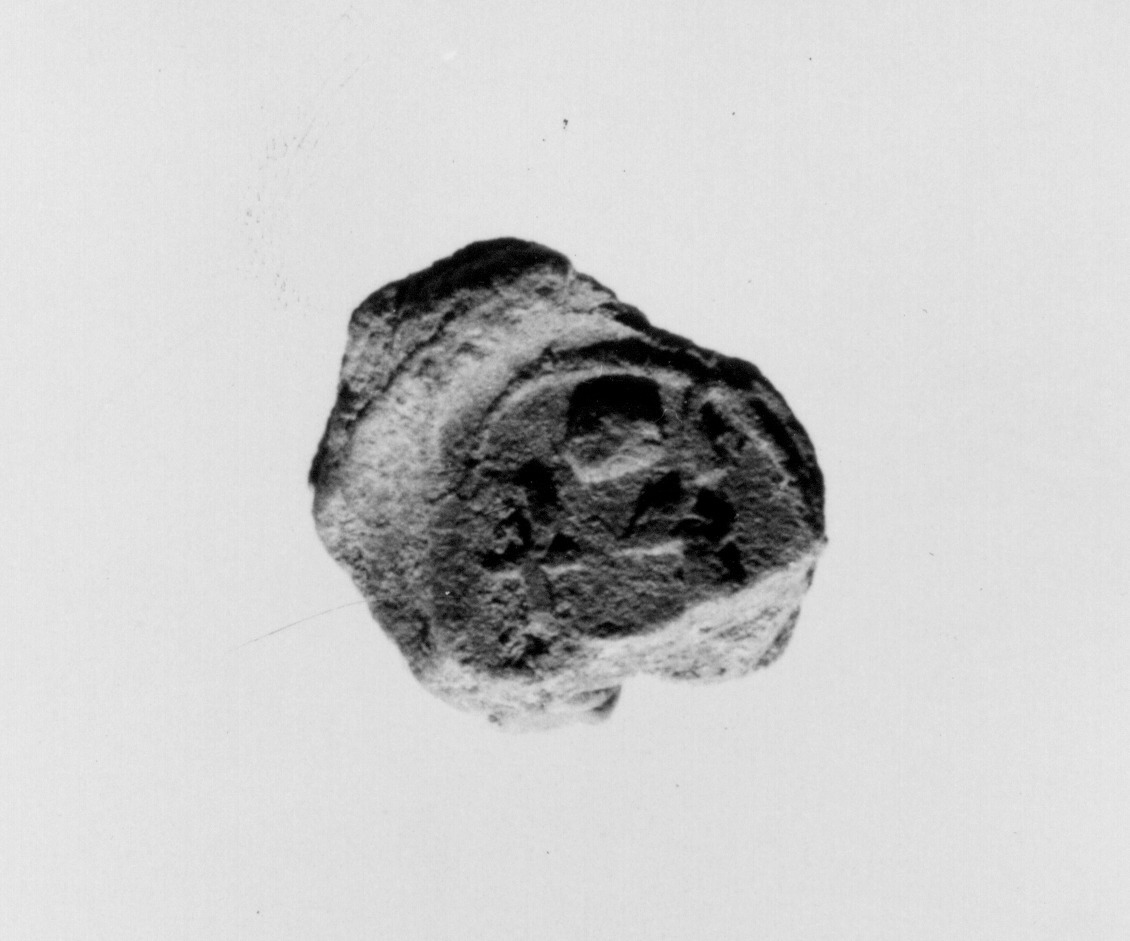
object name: sealing, nebmaatre, amenhotep iii,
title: Document Sealing With the Throne Name of Amenhotep III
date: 1390-1352 BCE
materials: mud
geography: egypt